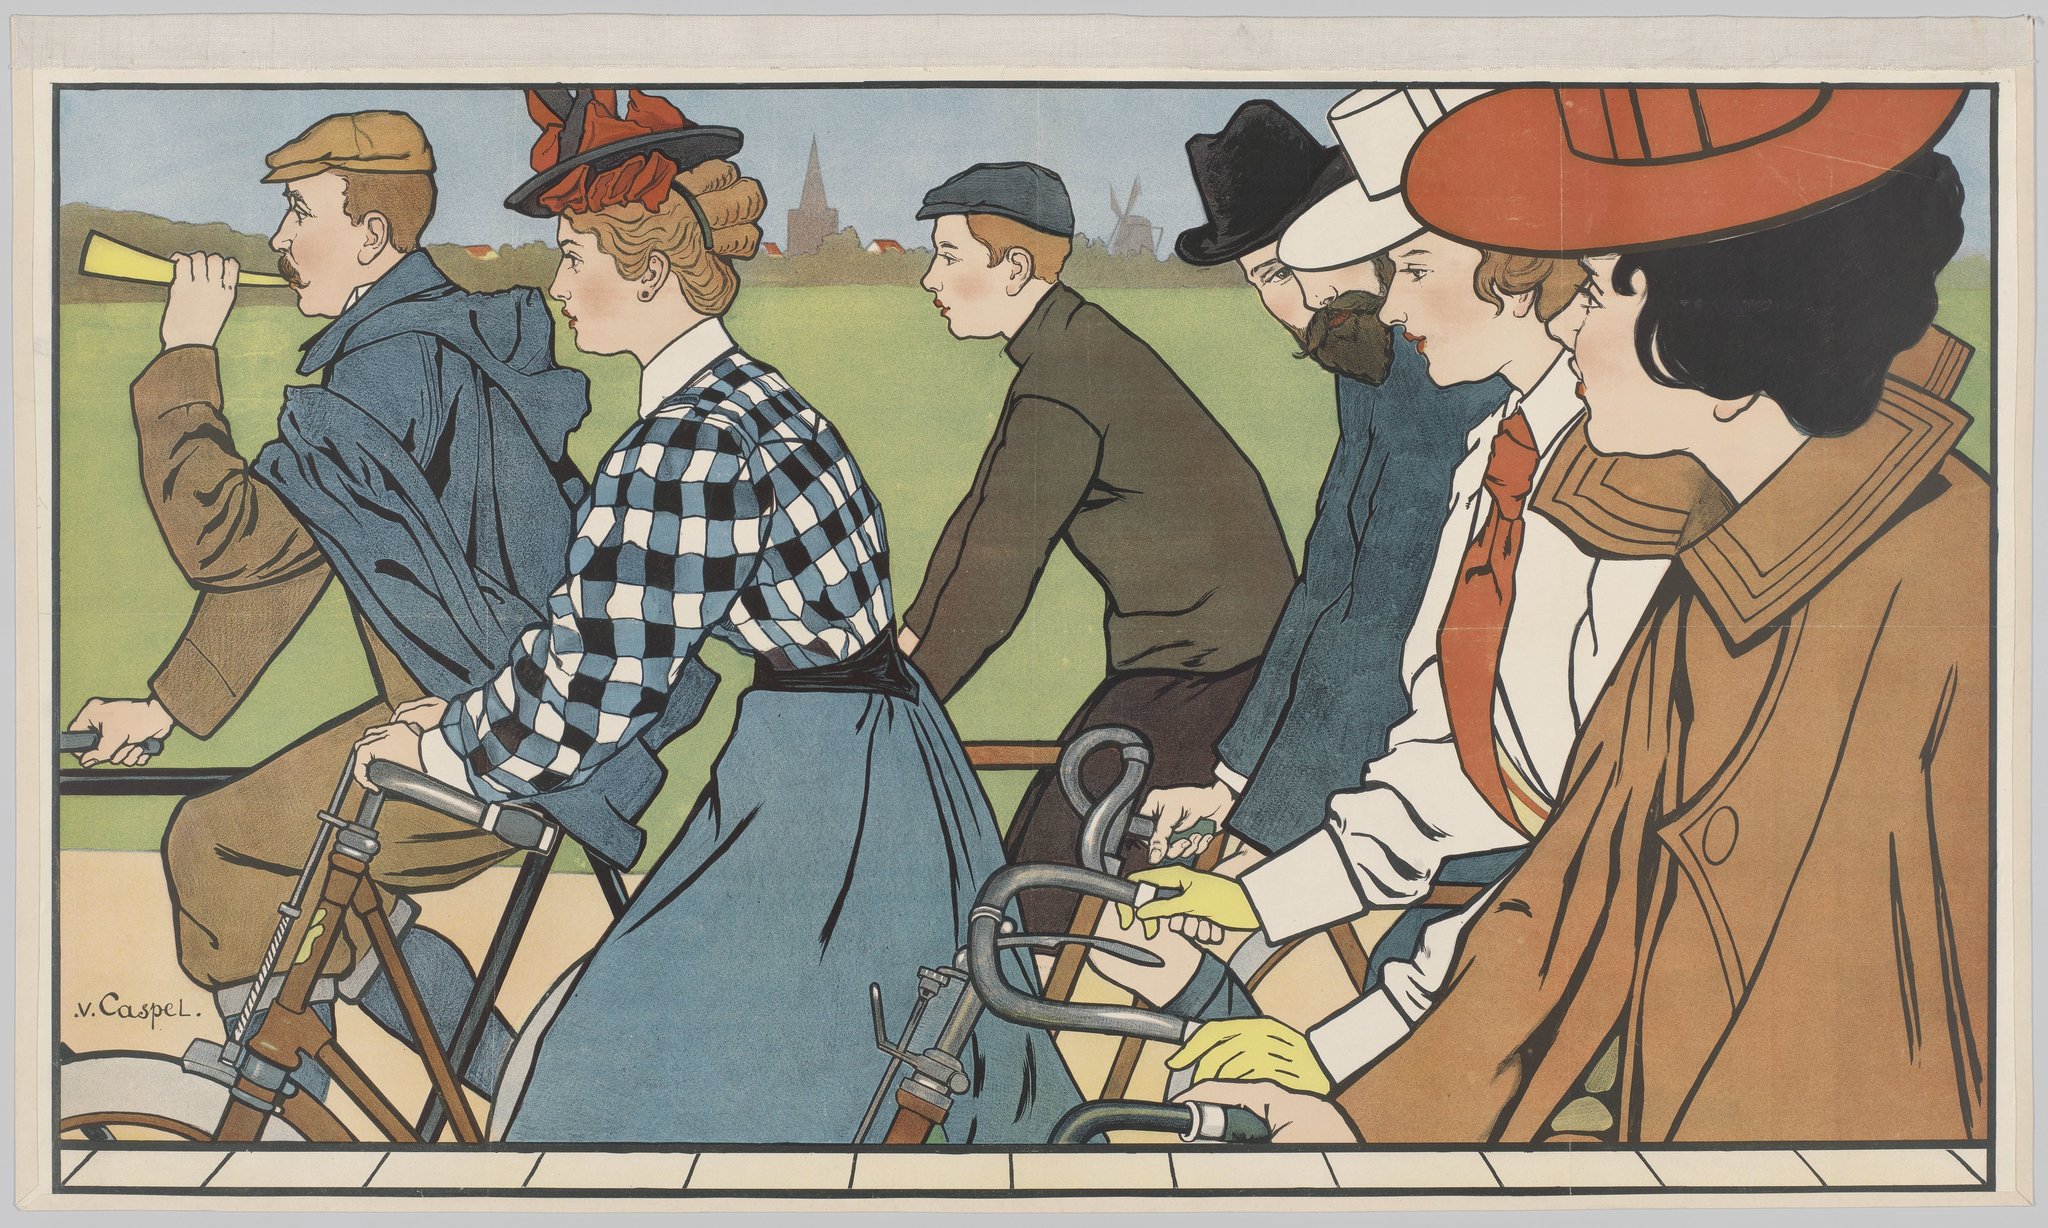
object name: poster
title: Hamers rijwielen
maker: johann georg van caspel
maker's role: draughtsman, print maker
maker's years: 1870-1928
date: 1912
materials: paper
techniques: lithograph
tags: bicycle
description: Affiche voor Hamers rijwielen, waarop afgebeeld zes fietsers in een Hollands landschap.